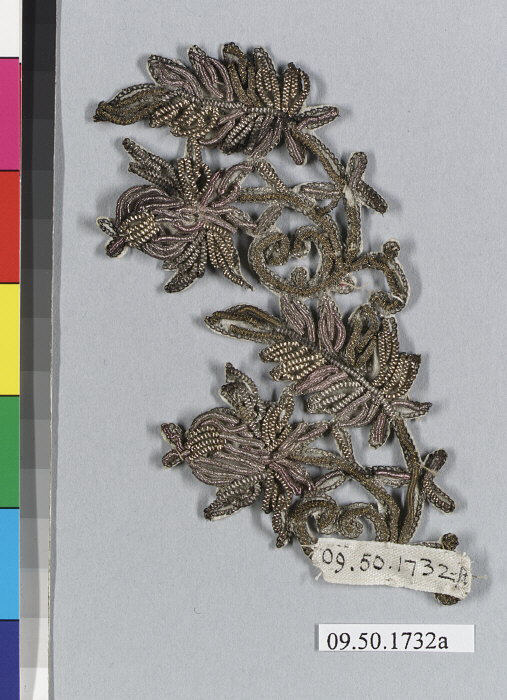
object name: ornament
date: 1801-1900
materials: metal thread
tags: plants